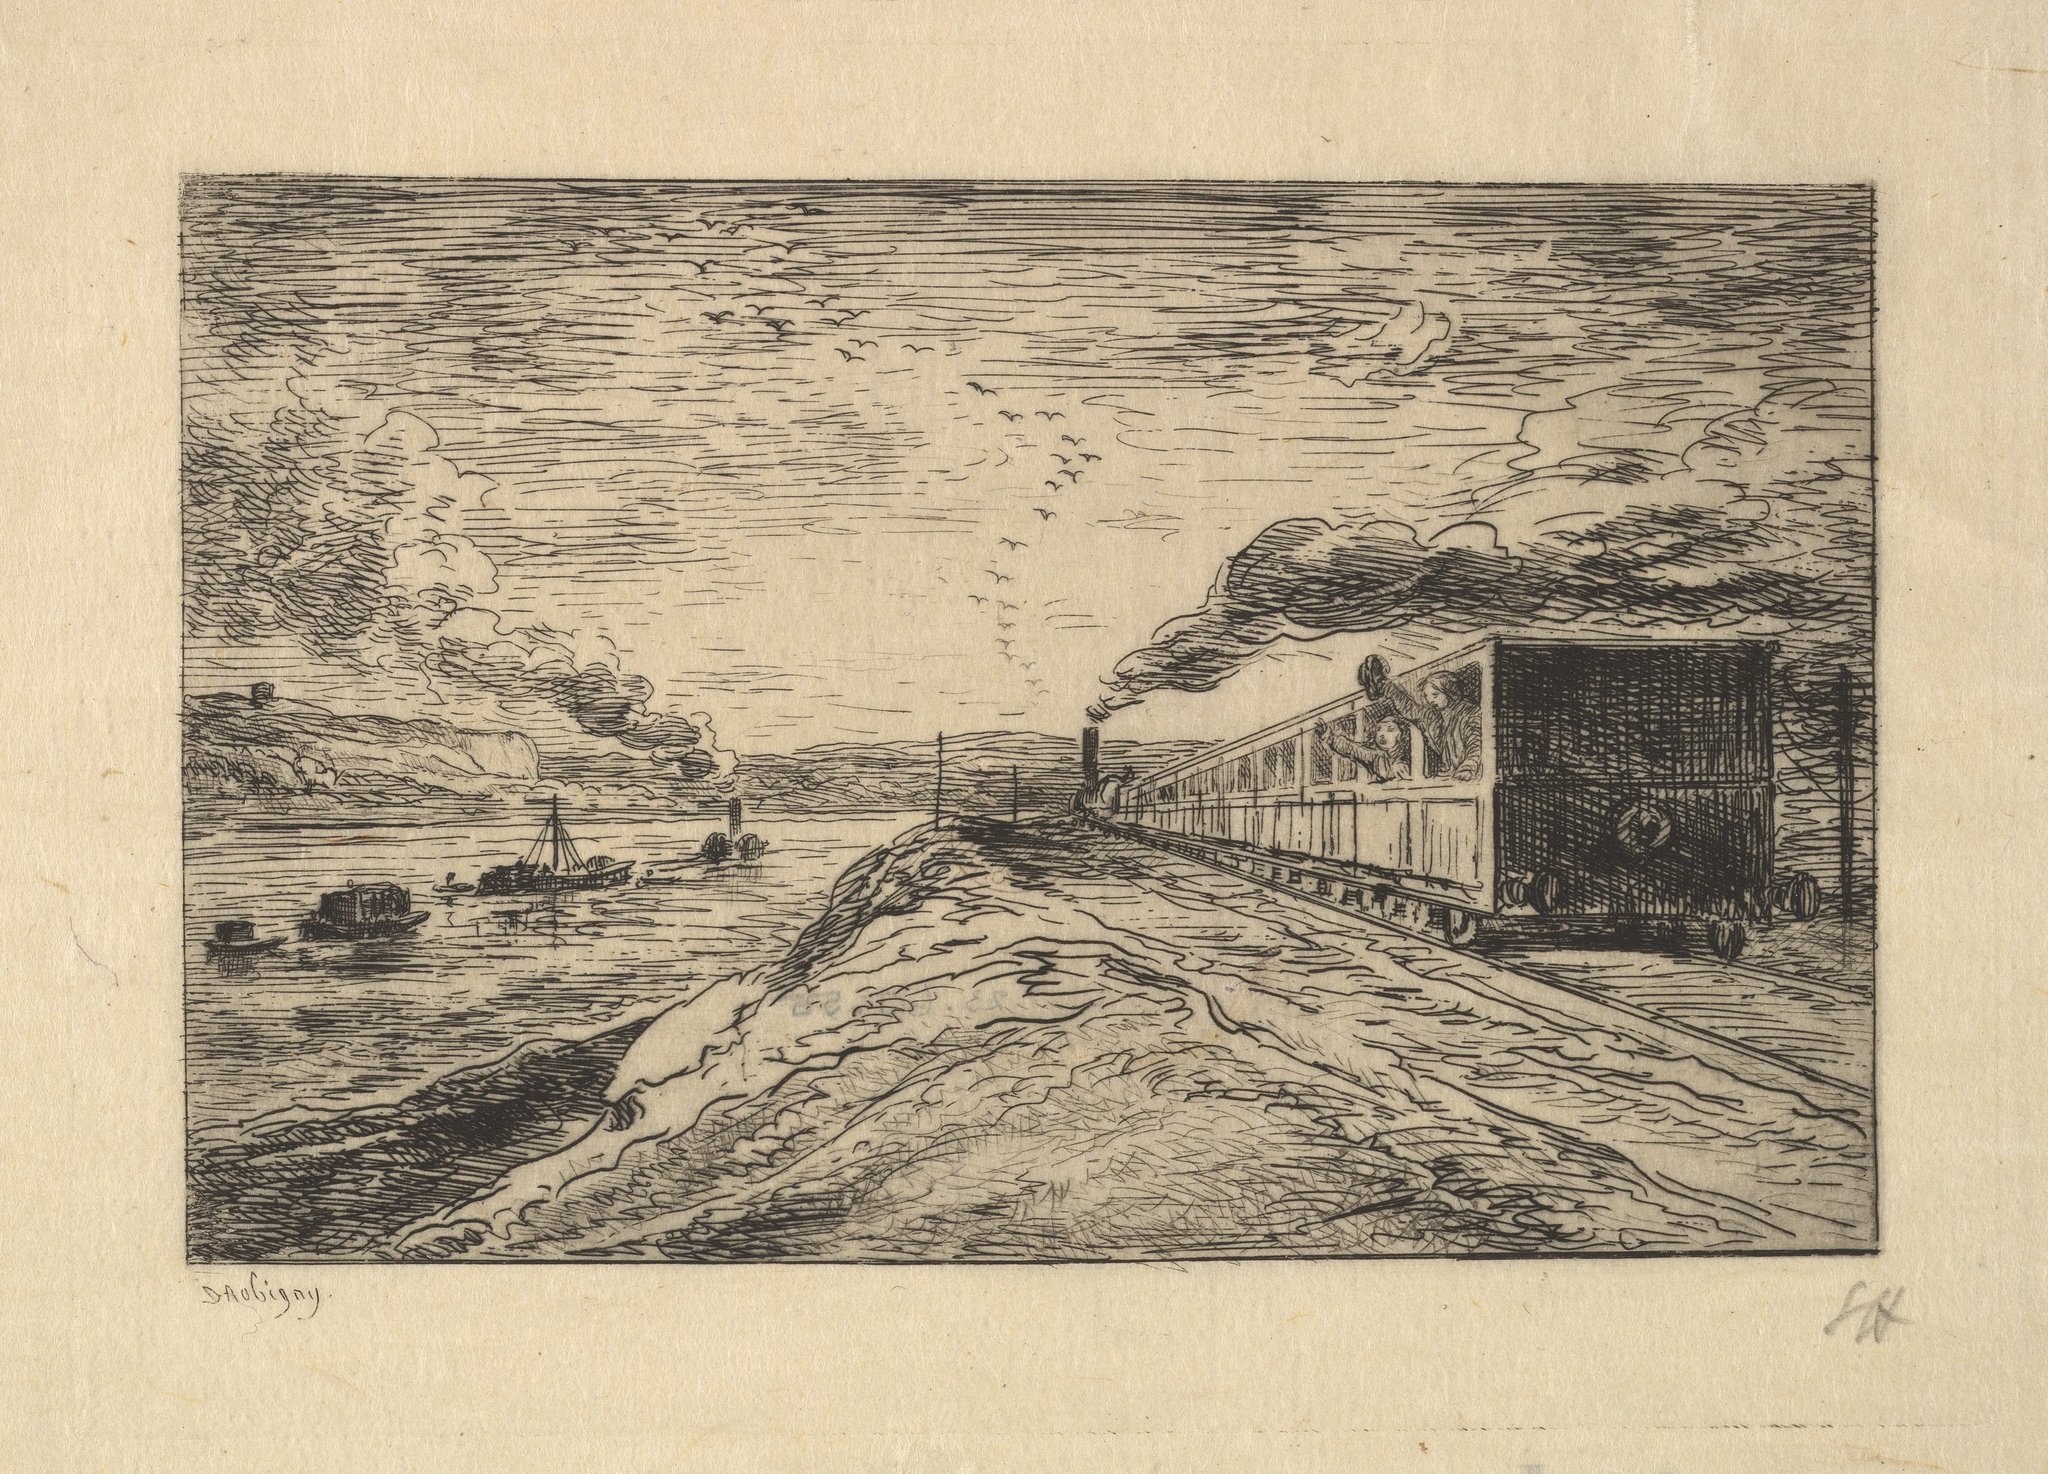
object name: print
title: The Departure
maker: charles-françois daubigny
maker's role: artist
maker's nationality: french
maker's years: 1817-1878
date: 1861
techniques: etching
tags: rivers,boats,trains